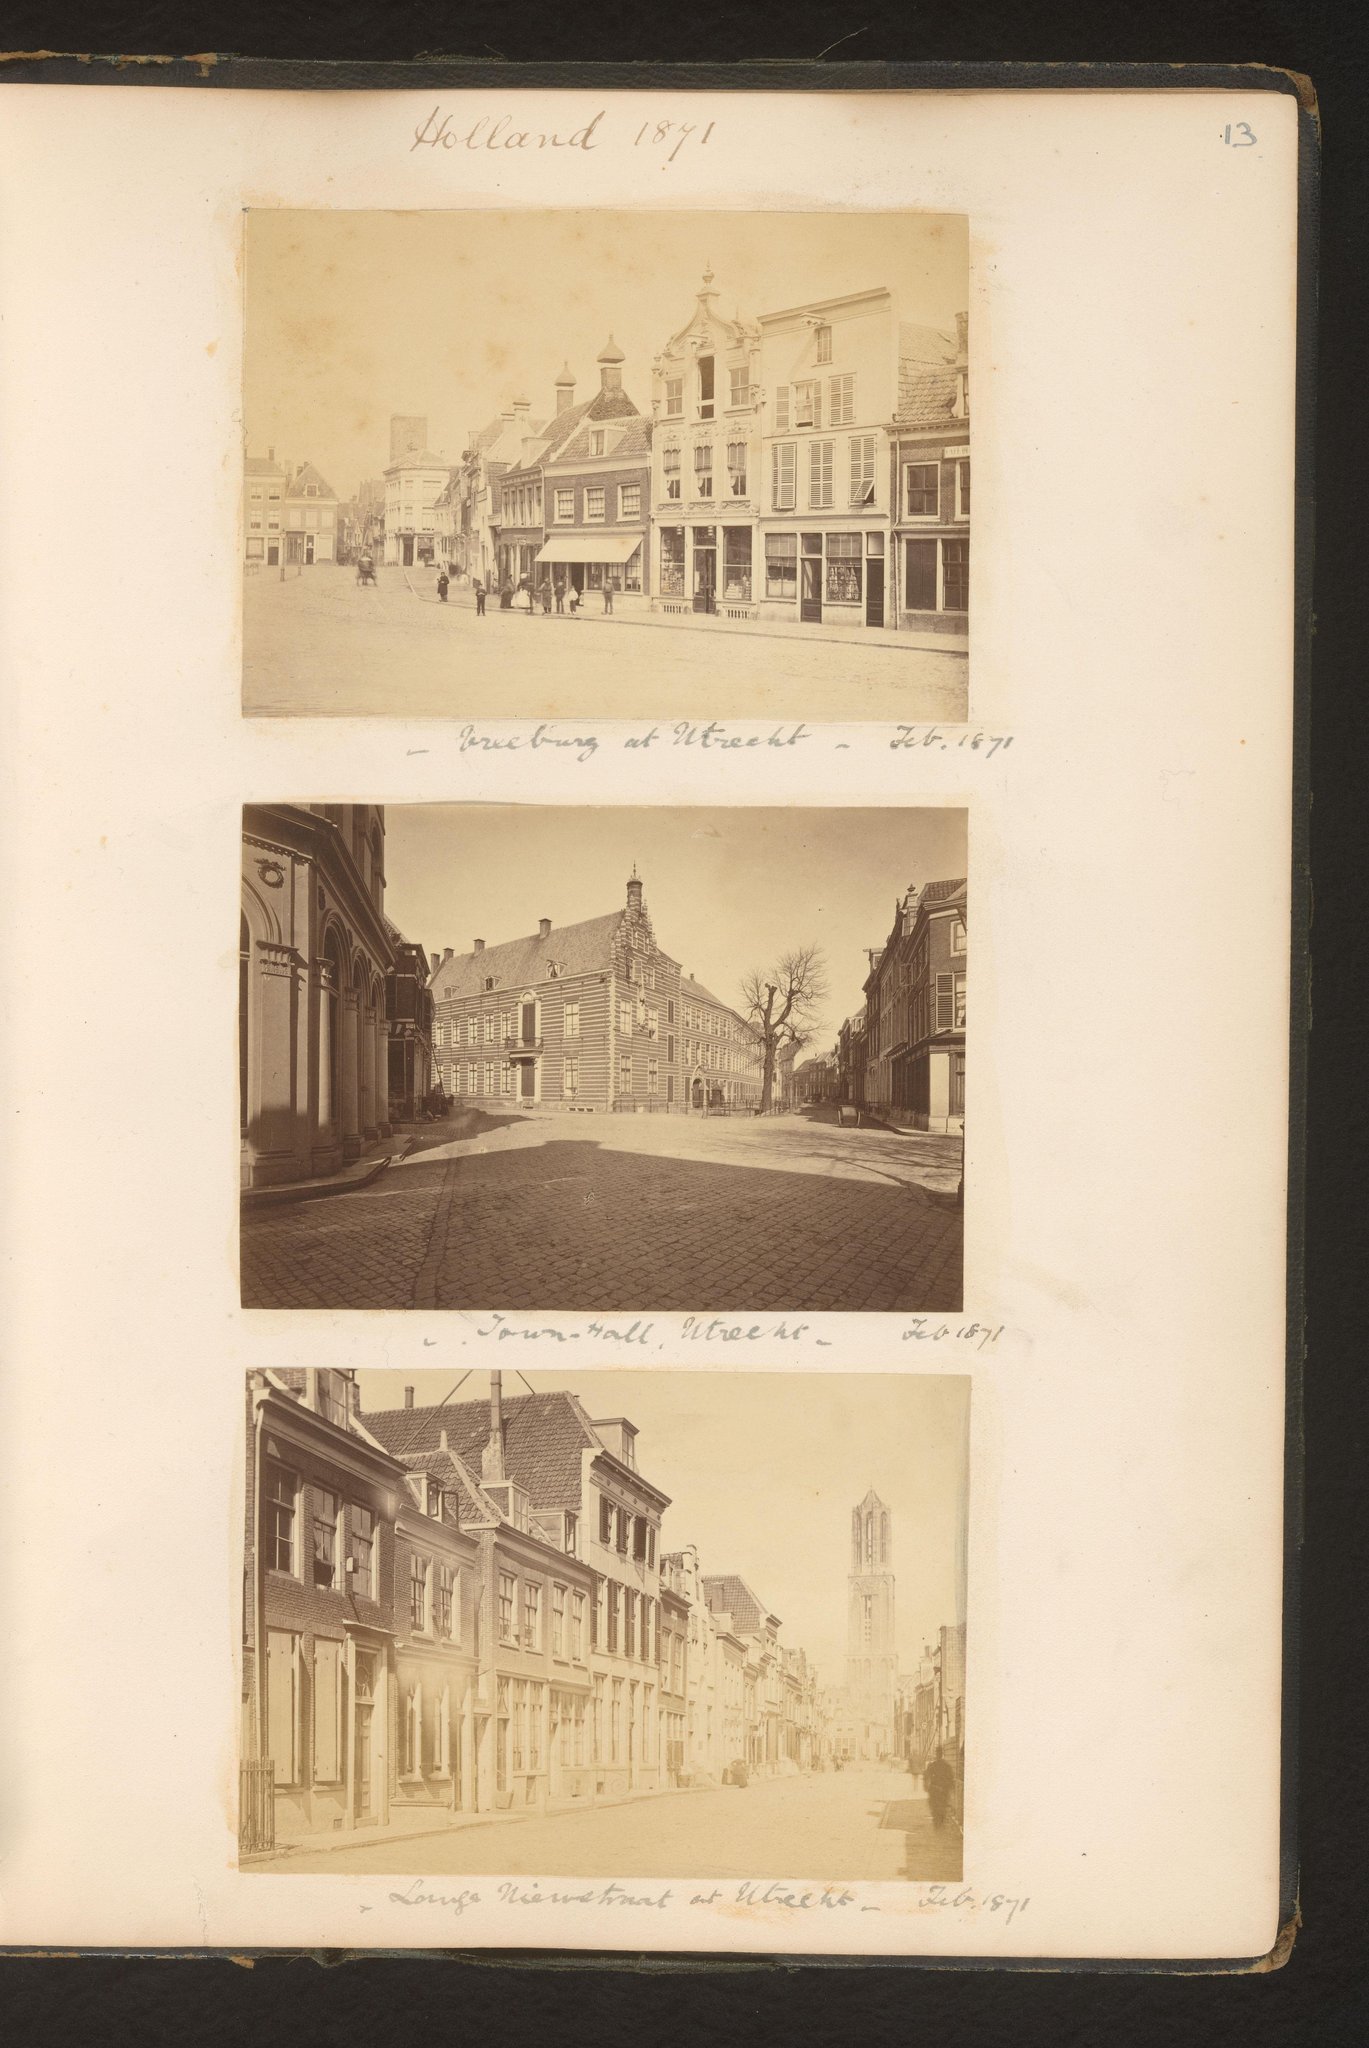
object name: album leaf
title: Gezichten op Utrecht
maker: Anonymous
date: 1802-1871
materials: paper, photographic support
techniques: albumen print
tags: civic architecture; edifices; dwellings, street, parts of church exterior and annexes: tower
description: Gezichten op Vredenburg, Paushuize en de Lange Nieuwstraat met uitzicht op de Dom. Deze pagina maakt deel uit van een album.